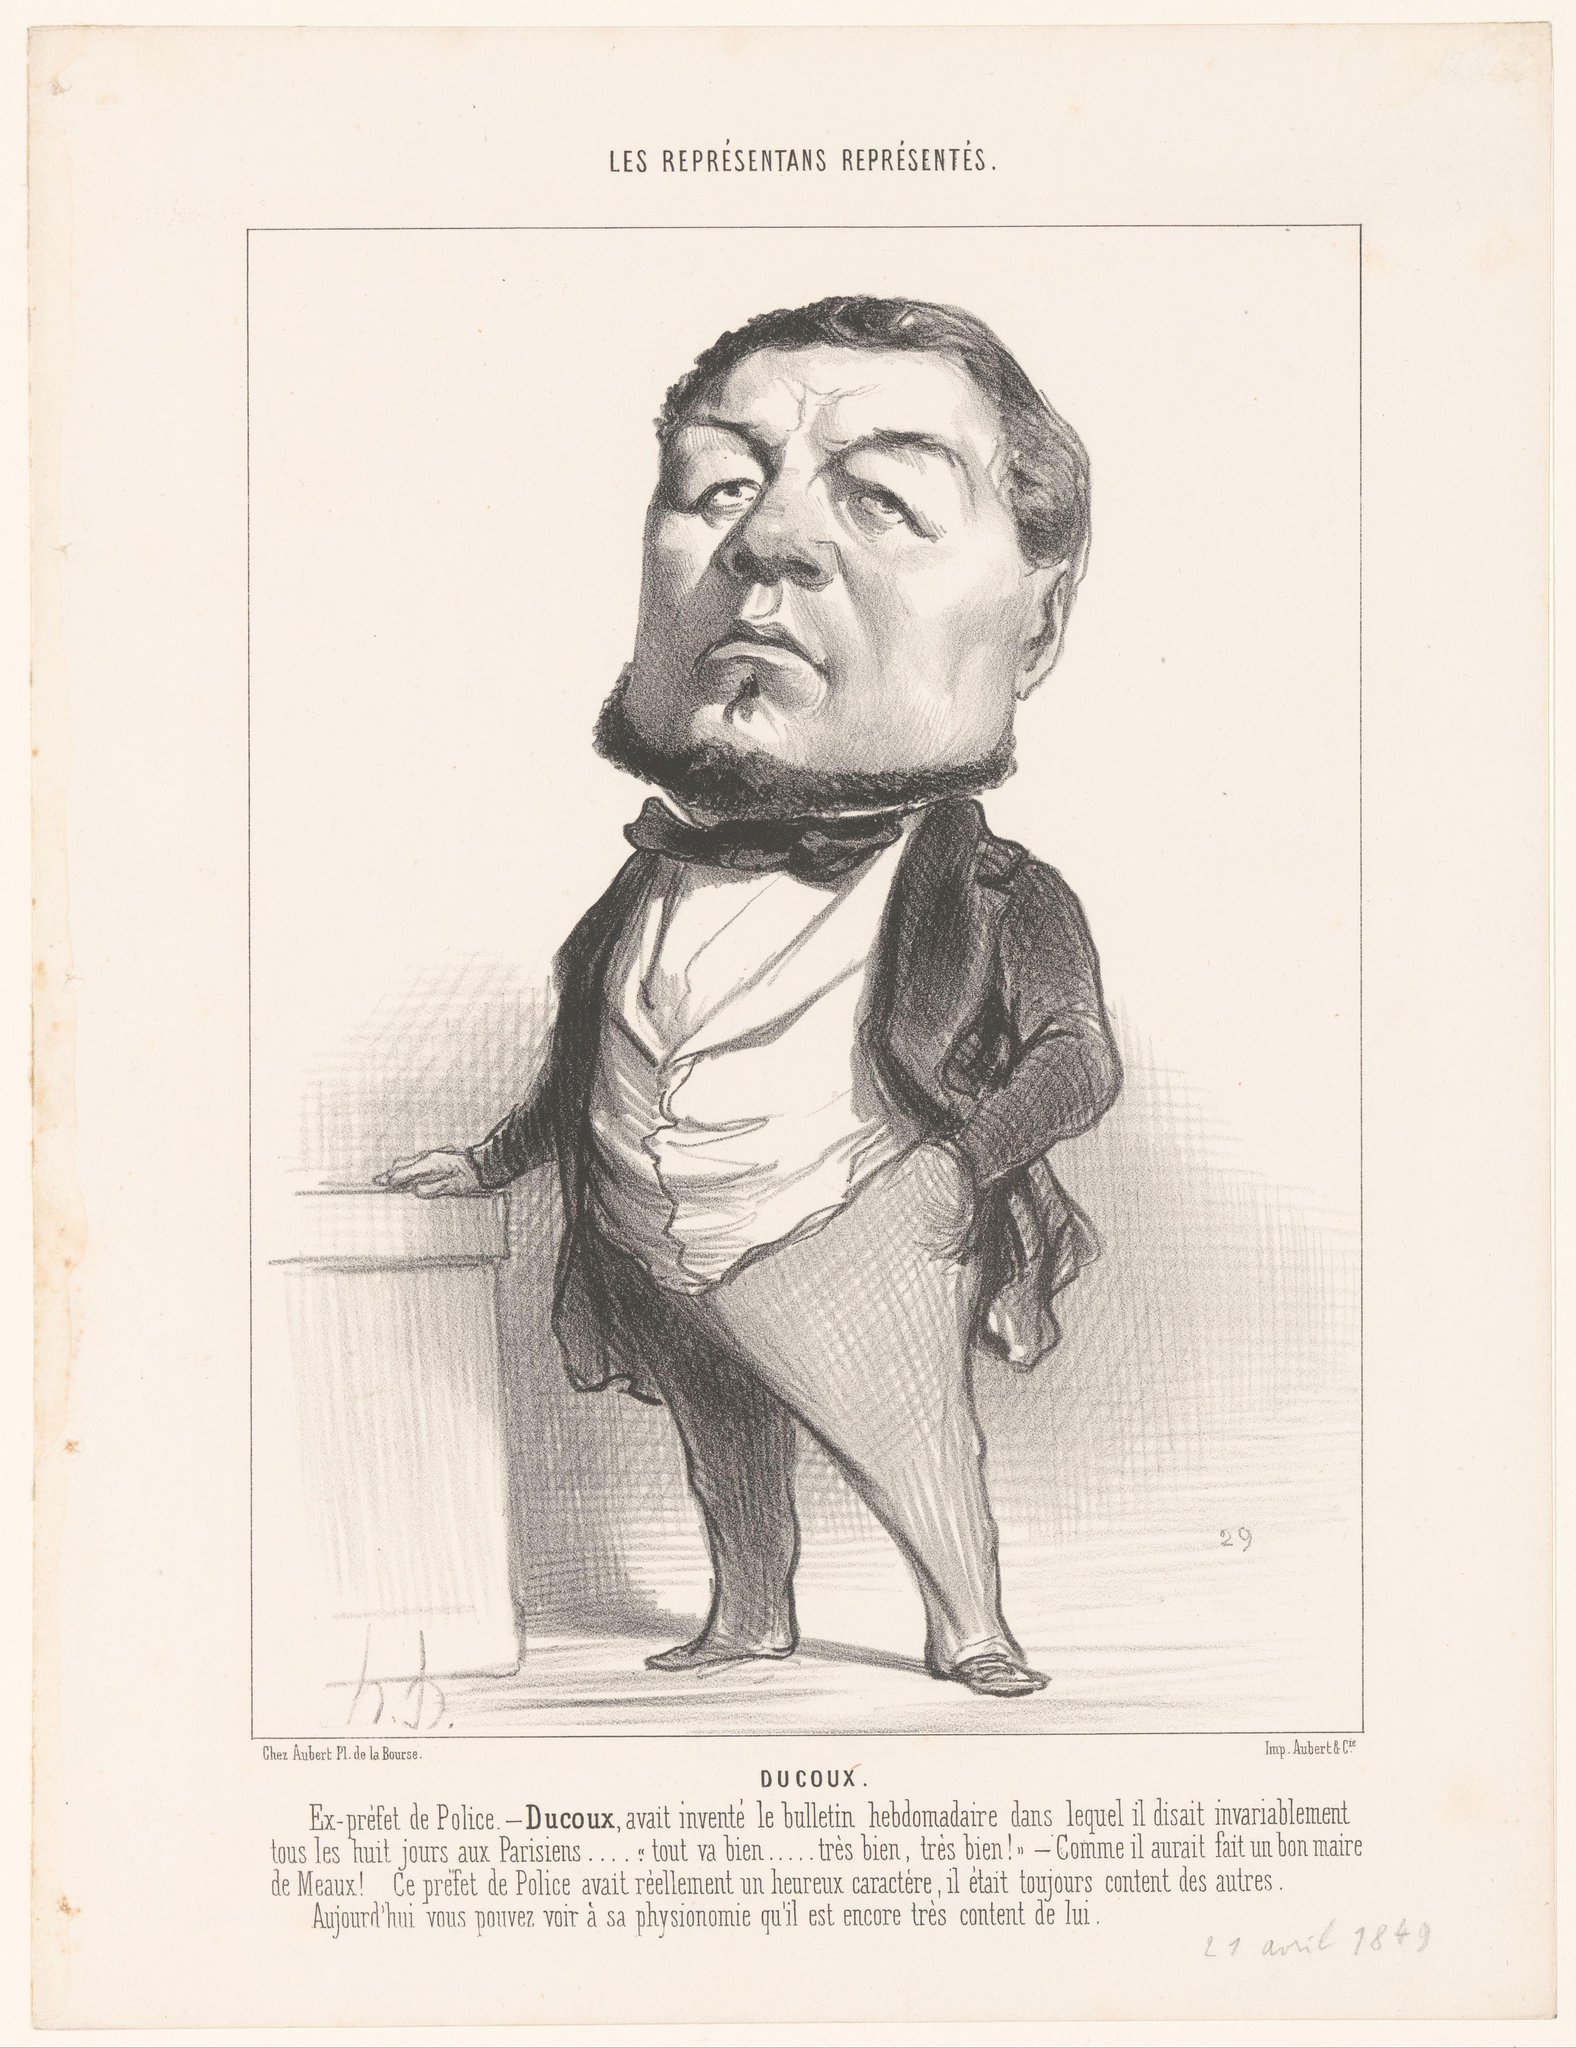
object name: cartoon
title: Les Representants Representés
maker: honoré daumier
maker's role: draughtsman, painter, print maker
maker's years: 1808-1879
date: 1849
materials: paper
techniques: lithograph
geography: paris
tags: caricatures (human types), historical persons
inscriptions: collector's mark: Lugt 2760, collector's mark: Lugt 2166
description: Prent gebruikt voor: Le Charivari, 21 april 1849.